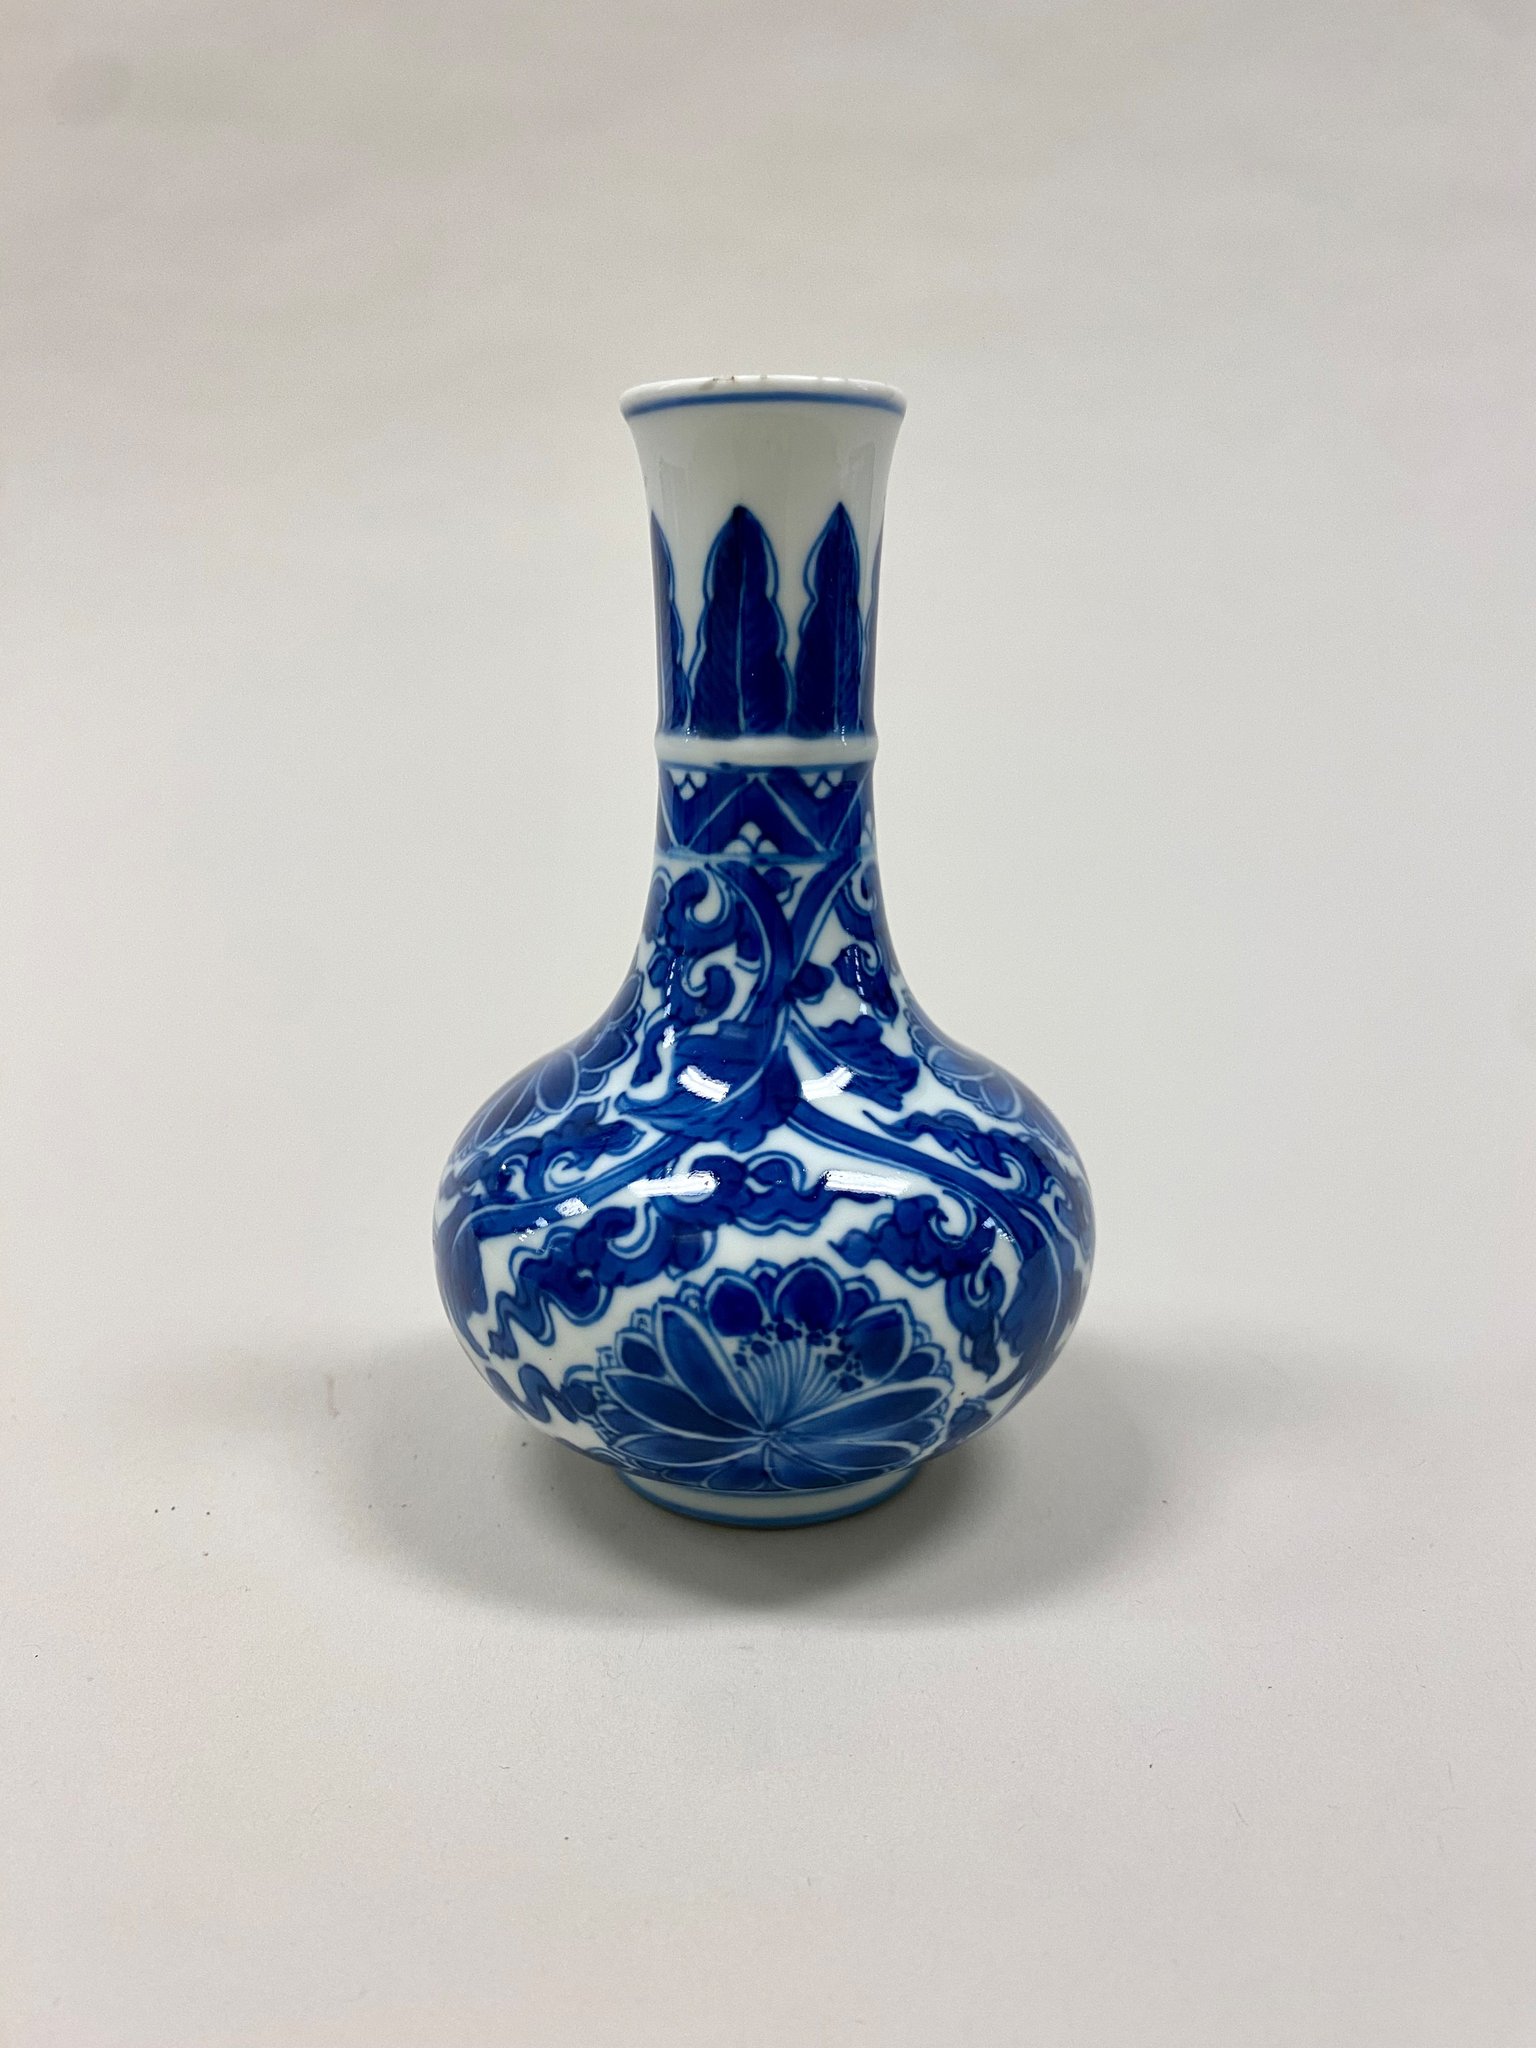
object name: bottle vase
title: Bottle vase with floral scrolls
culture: chinese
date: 1701-1733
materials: cobalt, porcelain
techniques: painting, underglaze